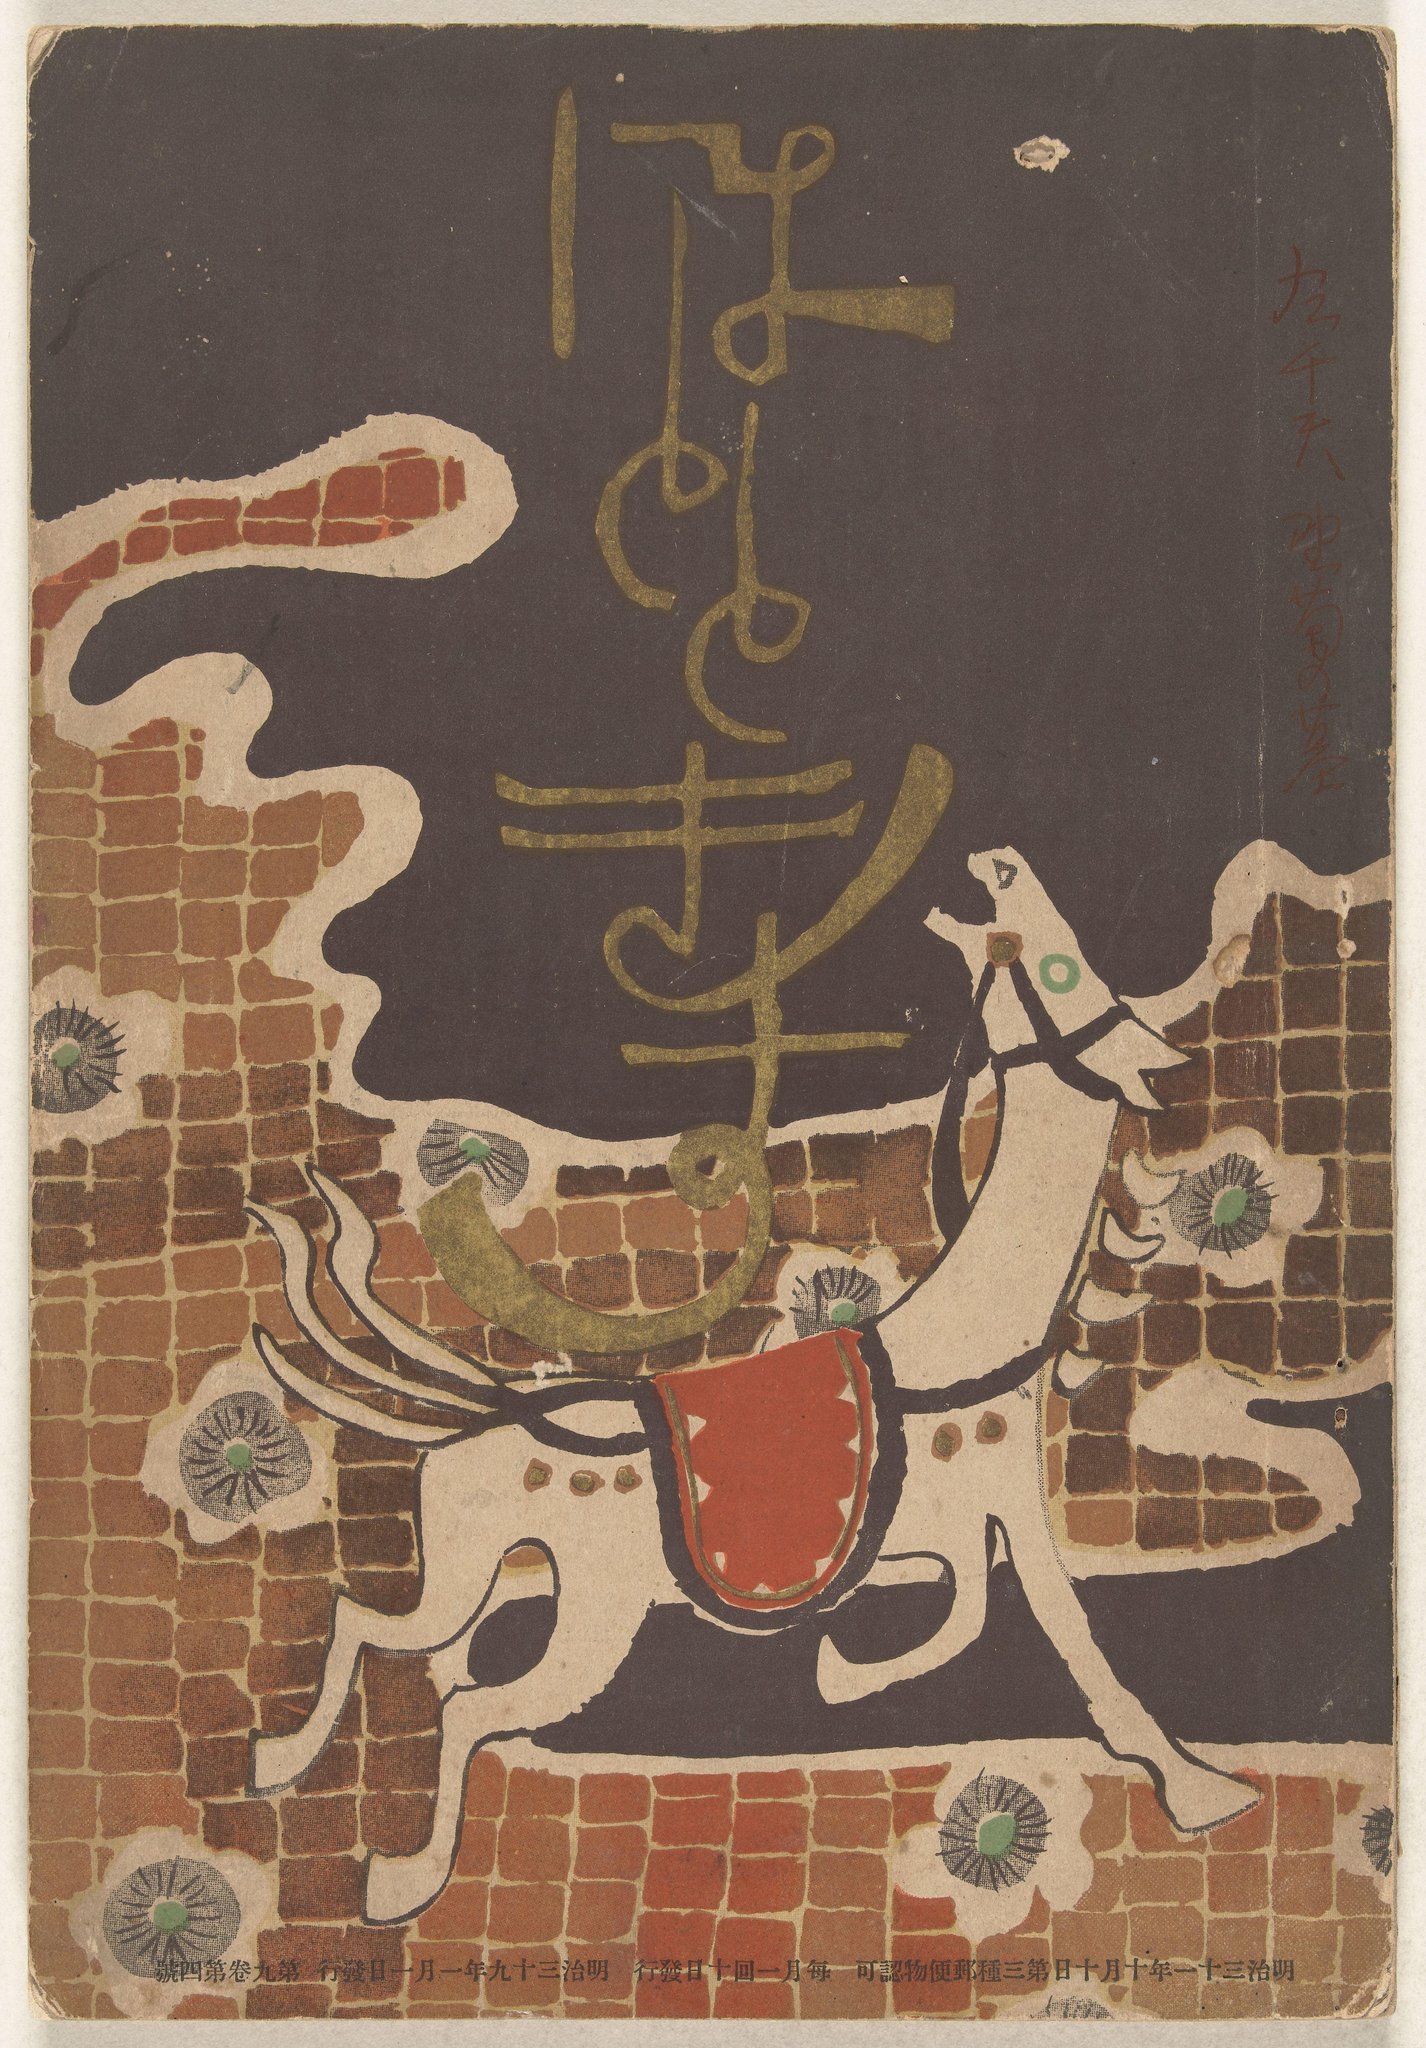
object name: magazine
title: Januari 1906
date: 1906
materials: paper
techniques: woodcut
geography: japan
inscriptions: date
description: Nummer 4 van jaargang 9 (januari 1906) van het literaire maandblad Hototogisu: bruine kaft met afbeelding van wit paard, opkijkend naar titel; binnenin frontispies van man met wit paard, persoon bij sikkelmaan en bloesemtak en boerenvrouw.